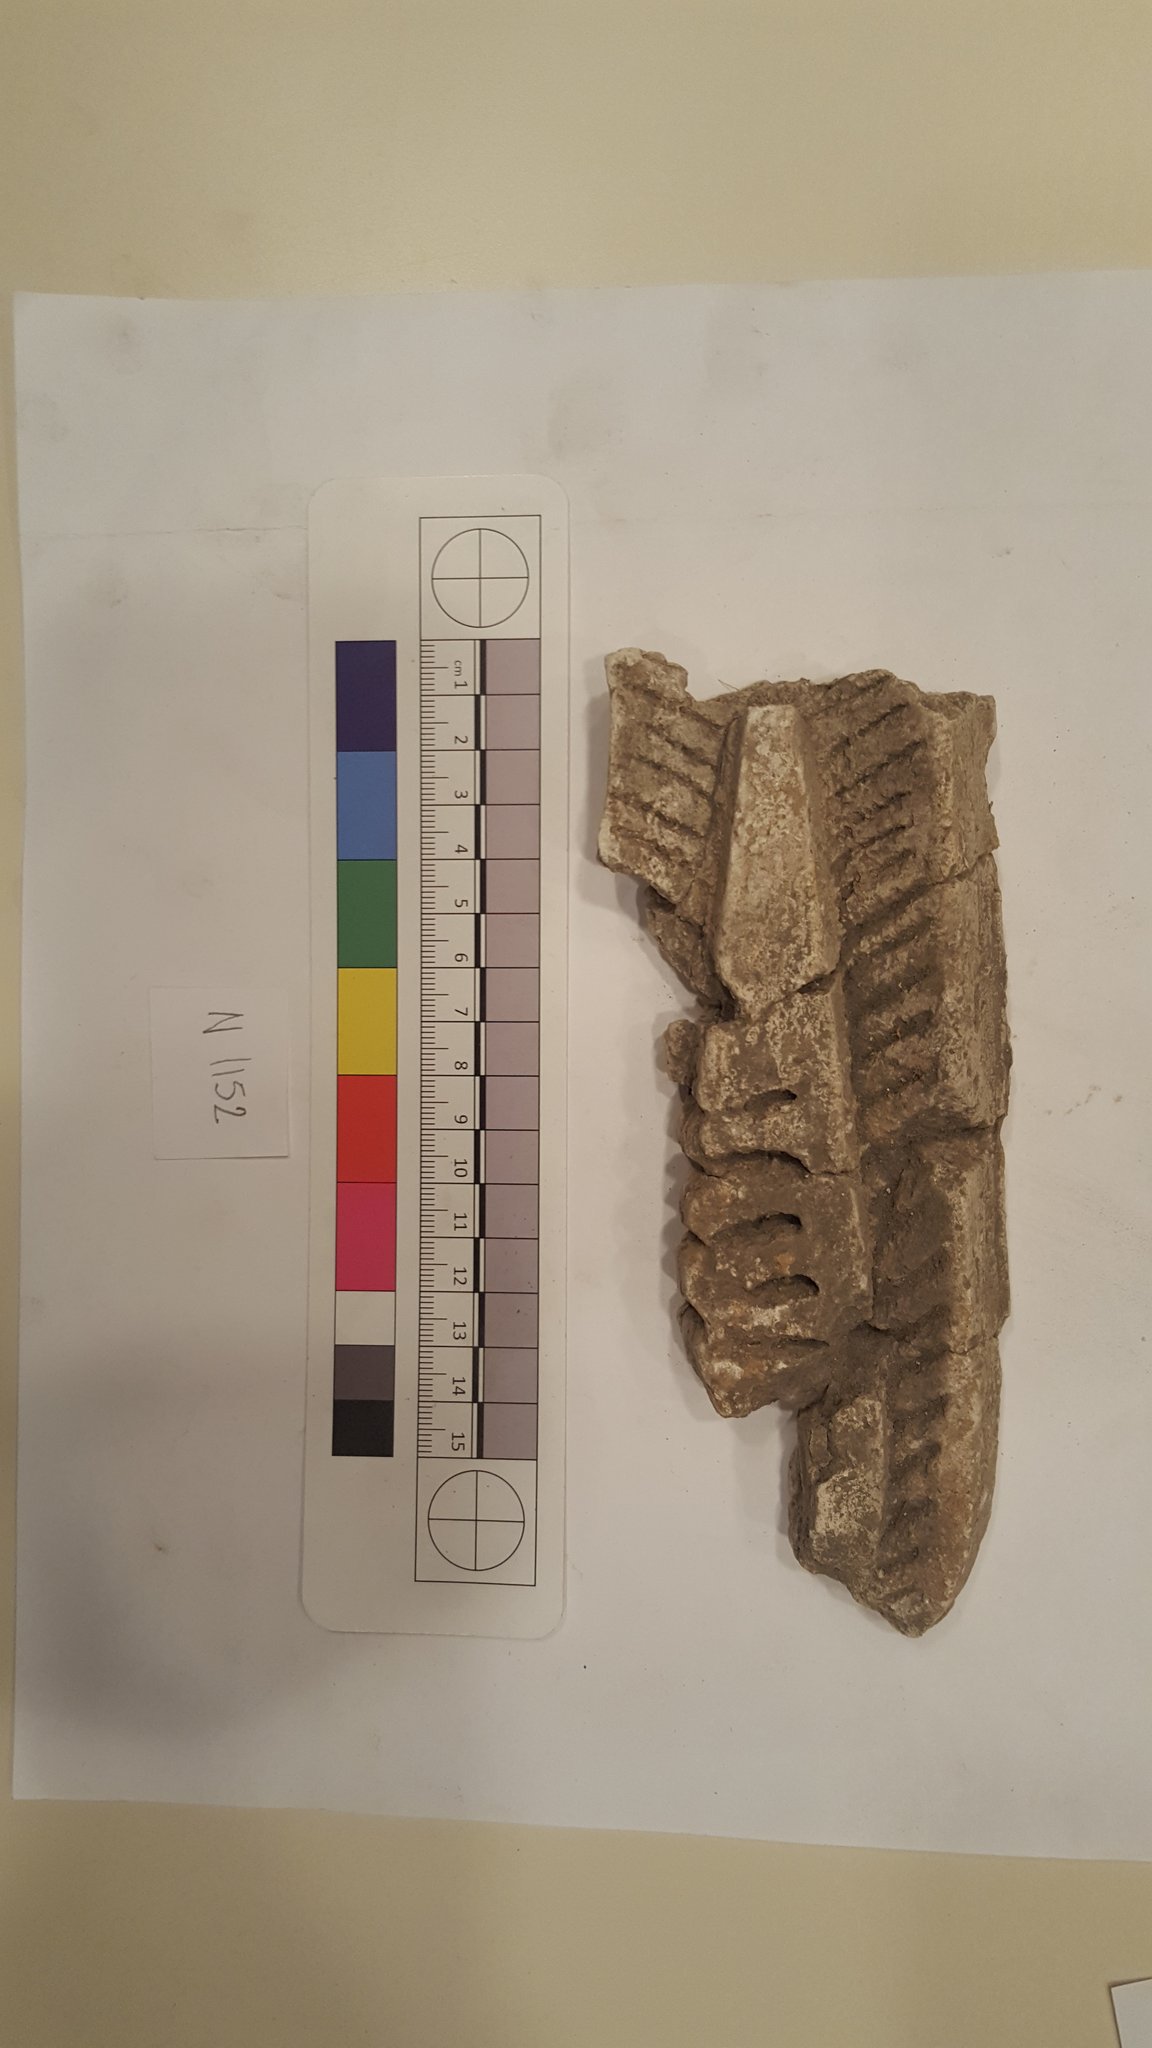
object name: fragment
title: Stucco Fragment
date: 701-1200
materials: plaster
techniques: carving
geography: iran